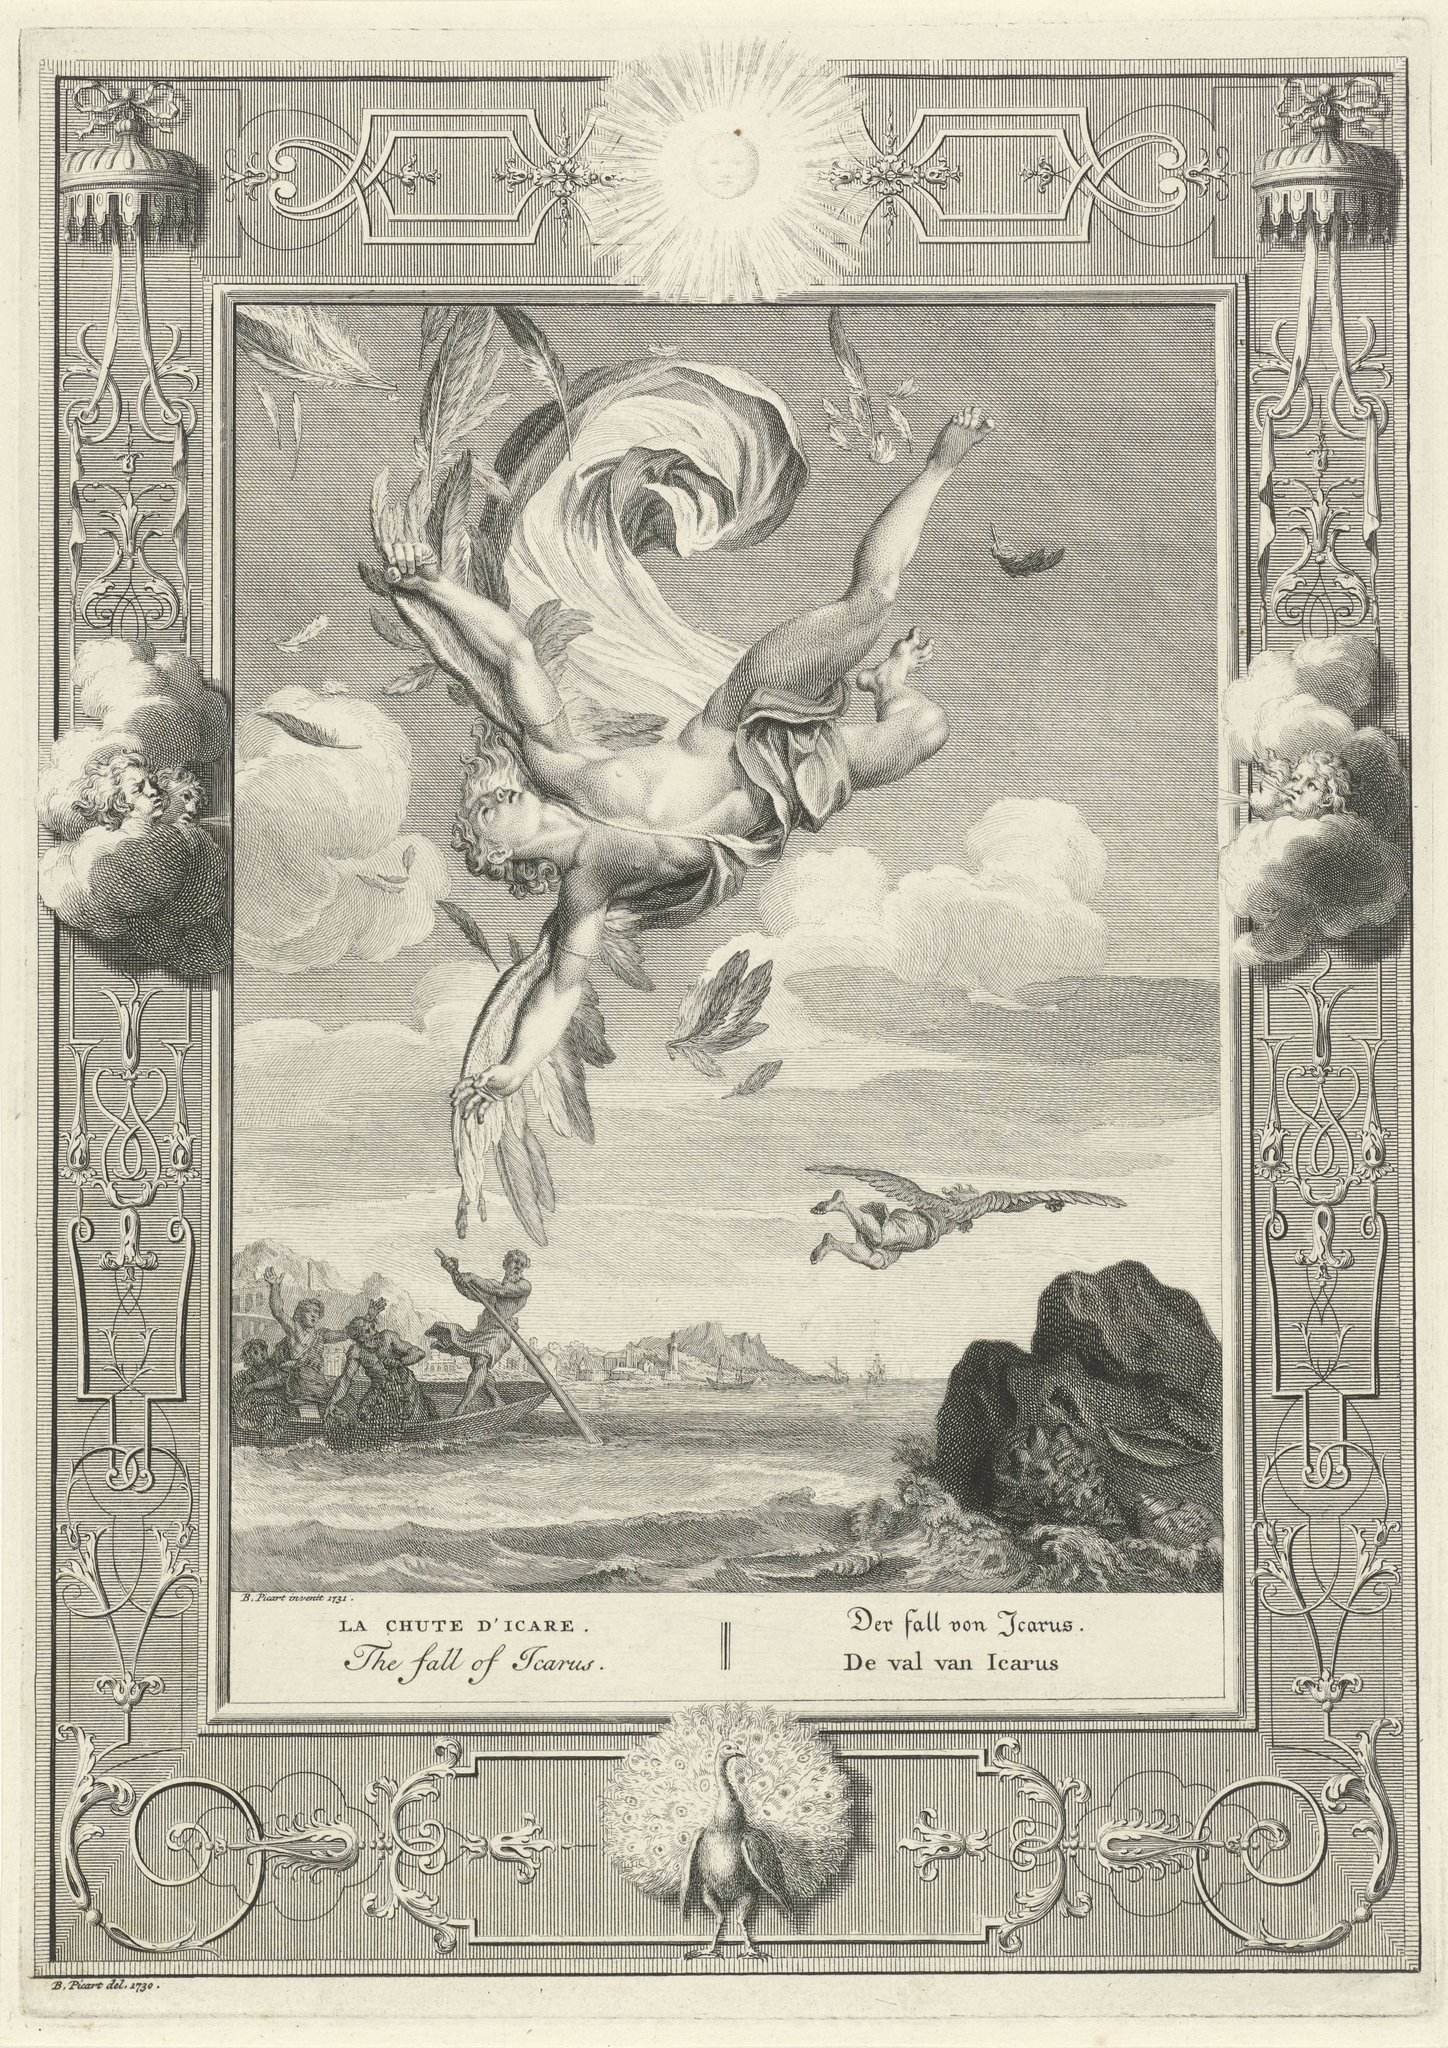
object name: print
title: De val van Icarus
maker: bernard picart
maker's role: draughtsman, print maker, publisher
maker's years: 1673-1733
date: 1730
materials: paper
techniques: engraving, etching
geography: amsterdam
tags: scrollwork, strapwork ~ ornament, death i.e. the fall of icarus (daedalus present)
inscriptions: collector's mark: Lugt 240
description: Icarus en zijn vader Daedalus ontsnappen van Kreta. Icarus vliegt echter te dicht bij de zon, waardoor de was van zijn vleugels smelt, zijn vleugels loslaten, en hij neerstort in zee. In de marge de titel in het Frans, Engels, Duits en Nederlands. De voorstelling is gedecoreerd met een ornamentele rand.